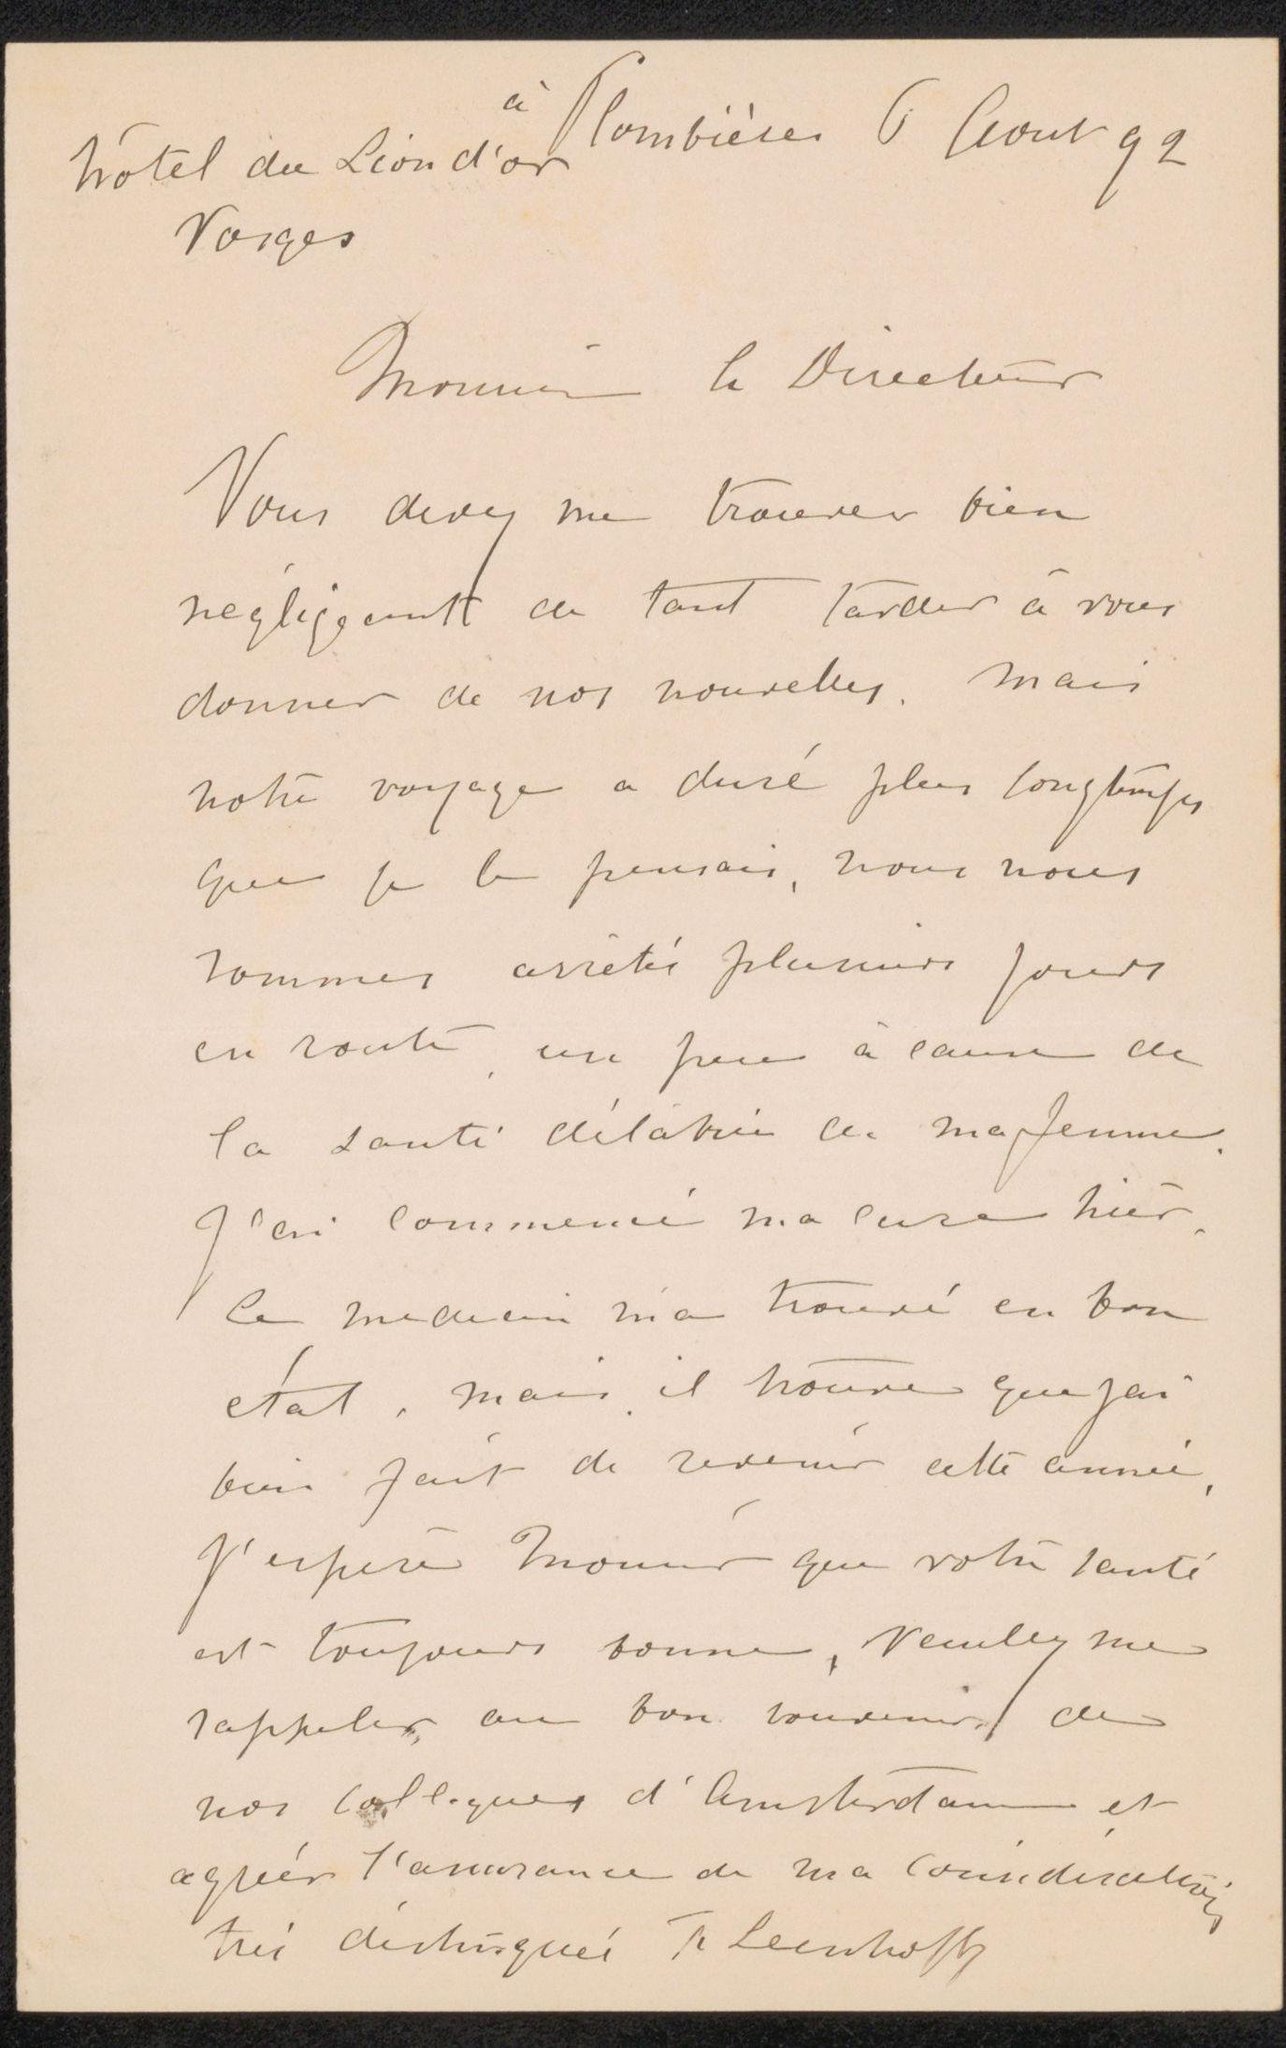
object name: letter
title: Brief aan August Allebé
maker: ferdinand leenhoff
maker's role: print maker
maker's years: 1841-1914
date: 1892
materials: ink, paper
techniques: pen, writing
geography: plombières-les-bains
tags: amsterdam, draughtsman, august allebé, travelling; tourism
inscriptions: watermark